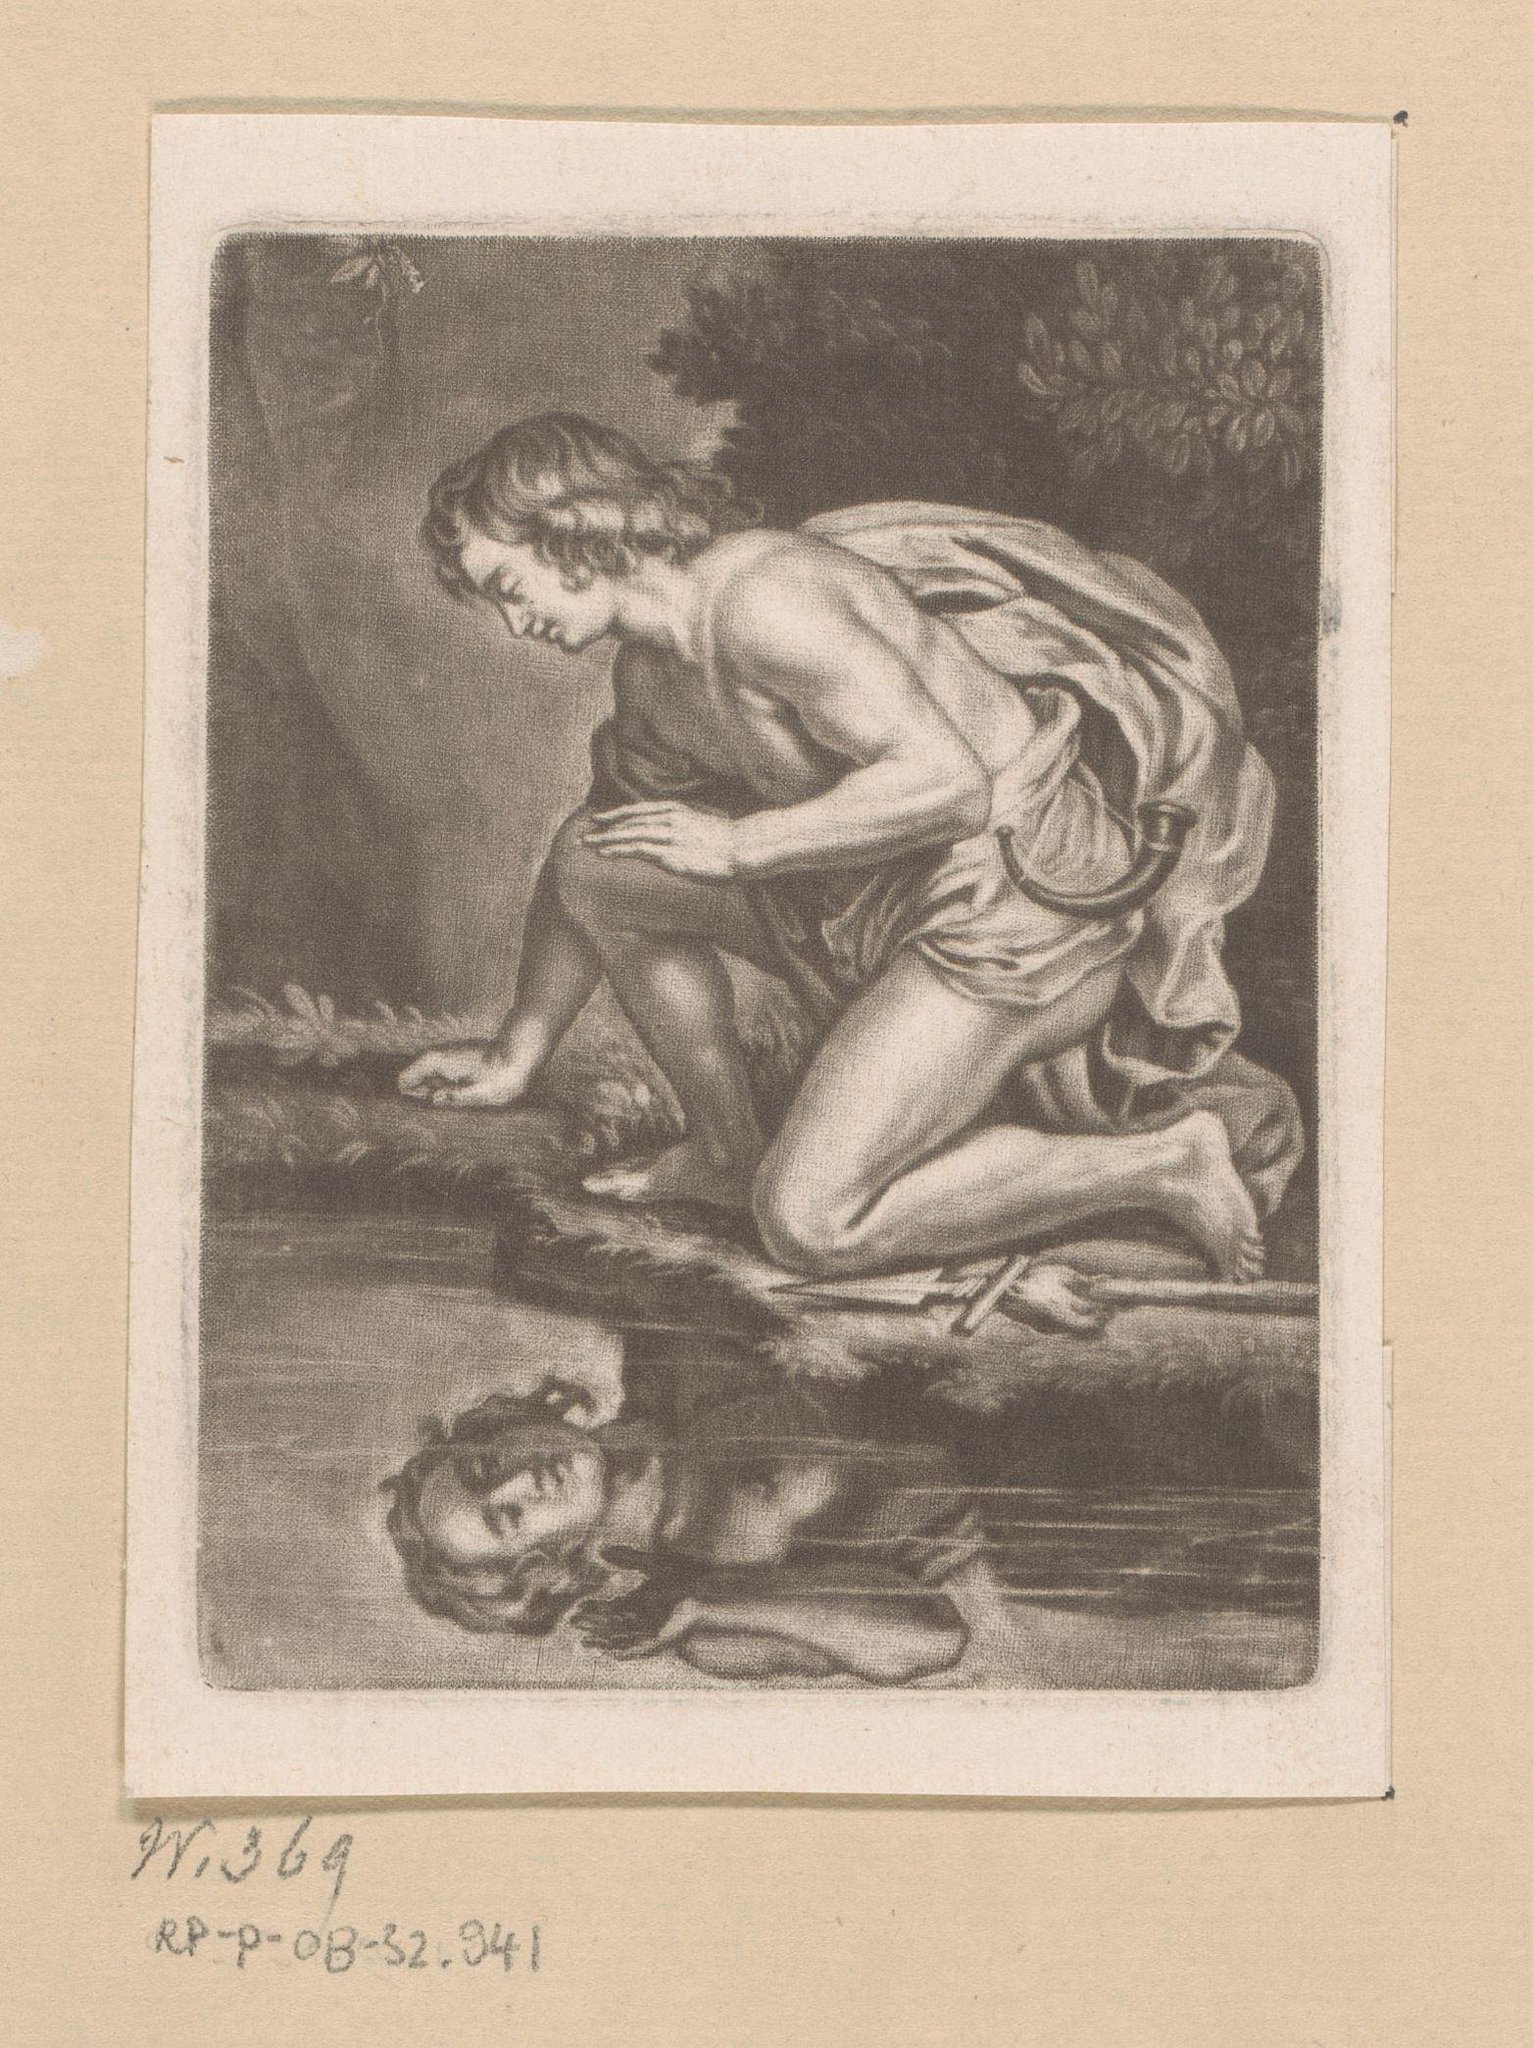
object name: print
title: Narcissus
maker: john smith (prentmaker/ uitgever)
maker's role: print maker, publisher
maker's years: 1652-1743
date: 1662-1742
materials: paper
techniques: mezzotint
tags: (story of) narcissus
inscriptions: collector's mark: Lugt 240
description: Voor ander exemplaar zie: RP-P-1910-1638.